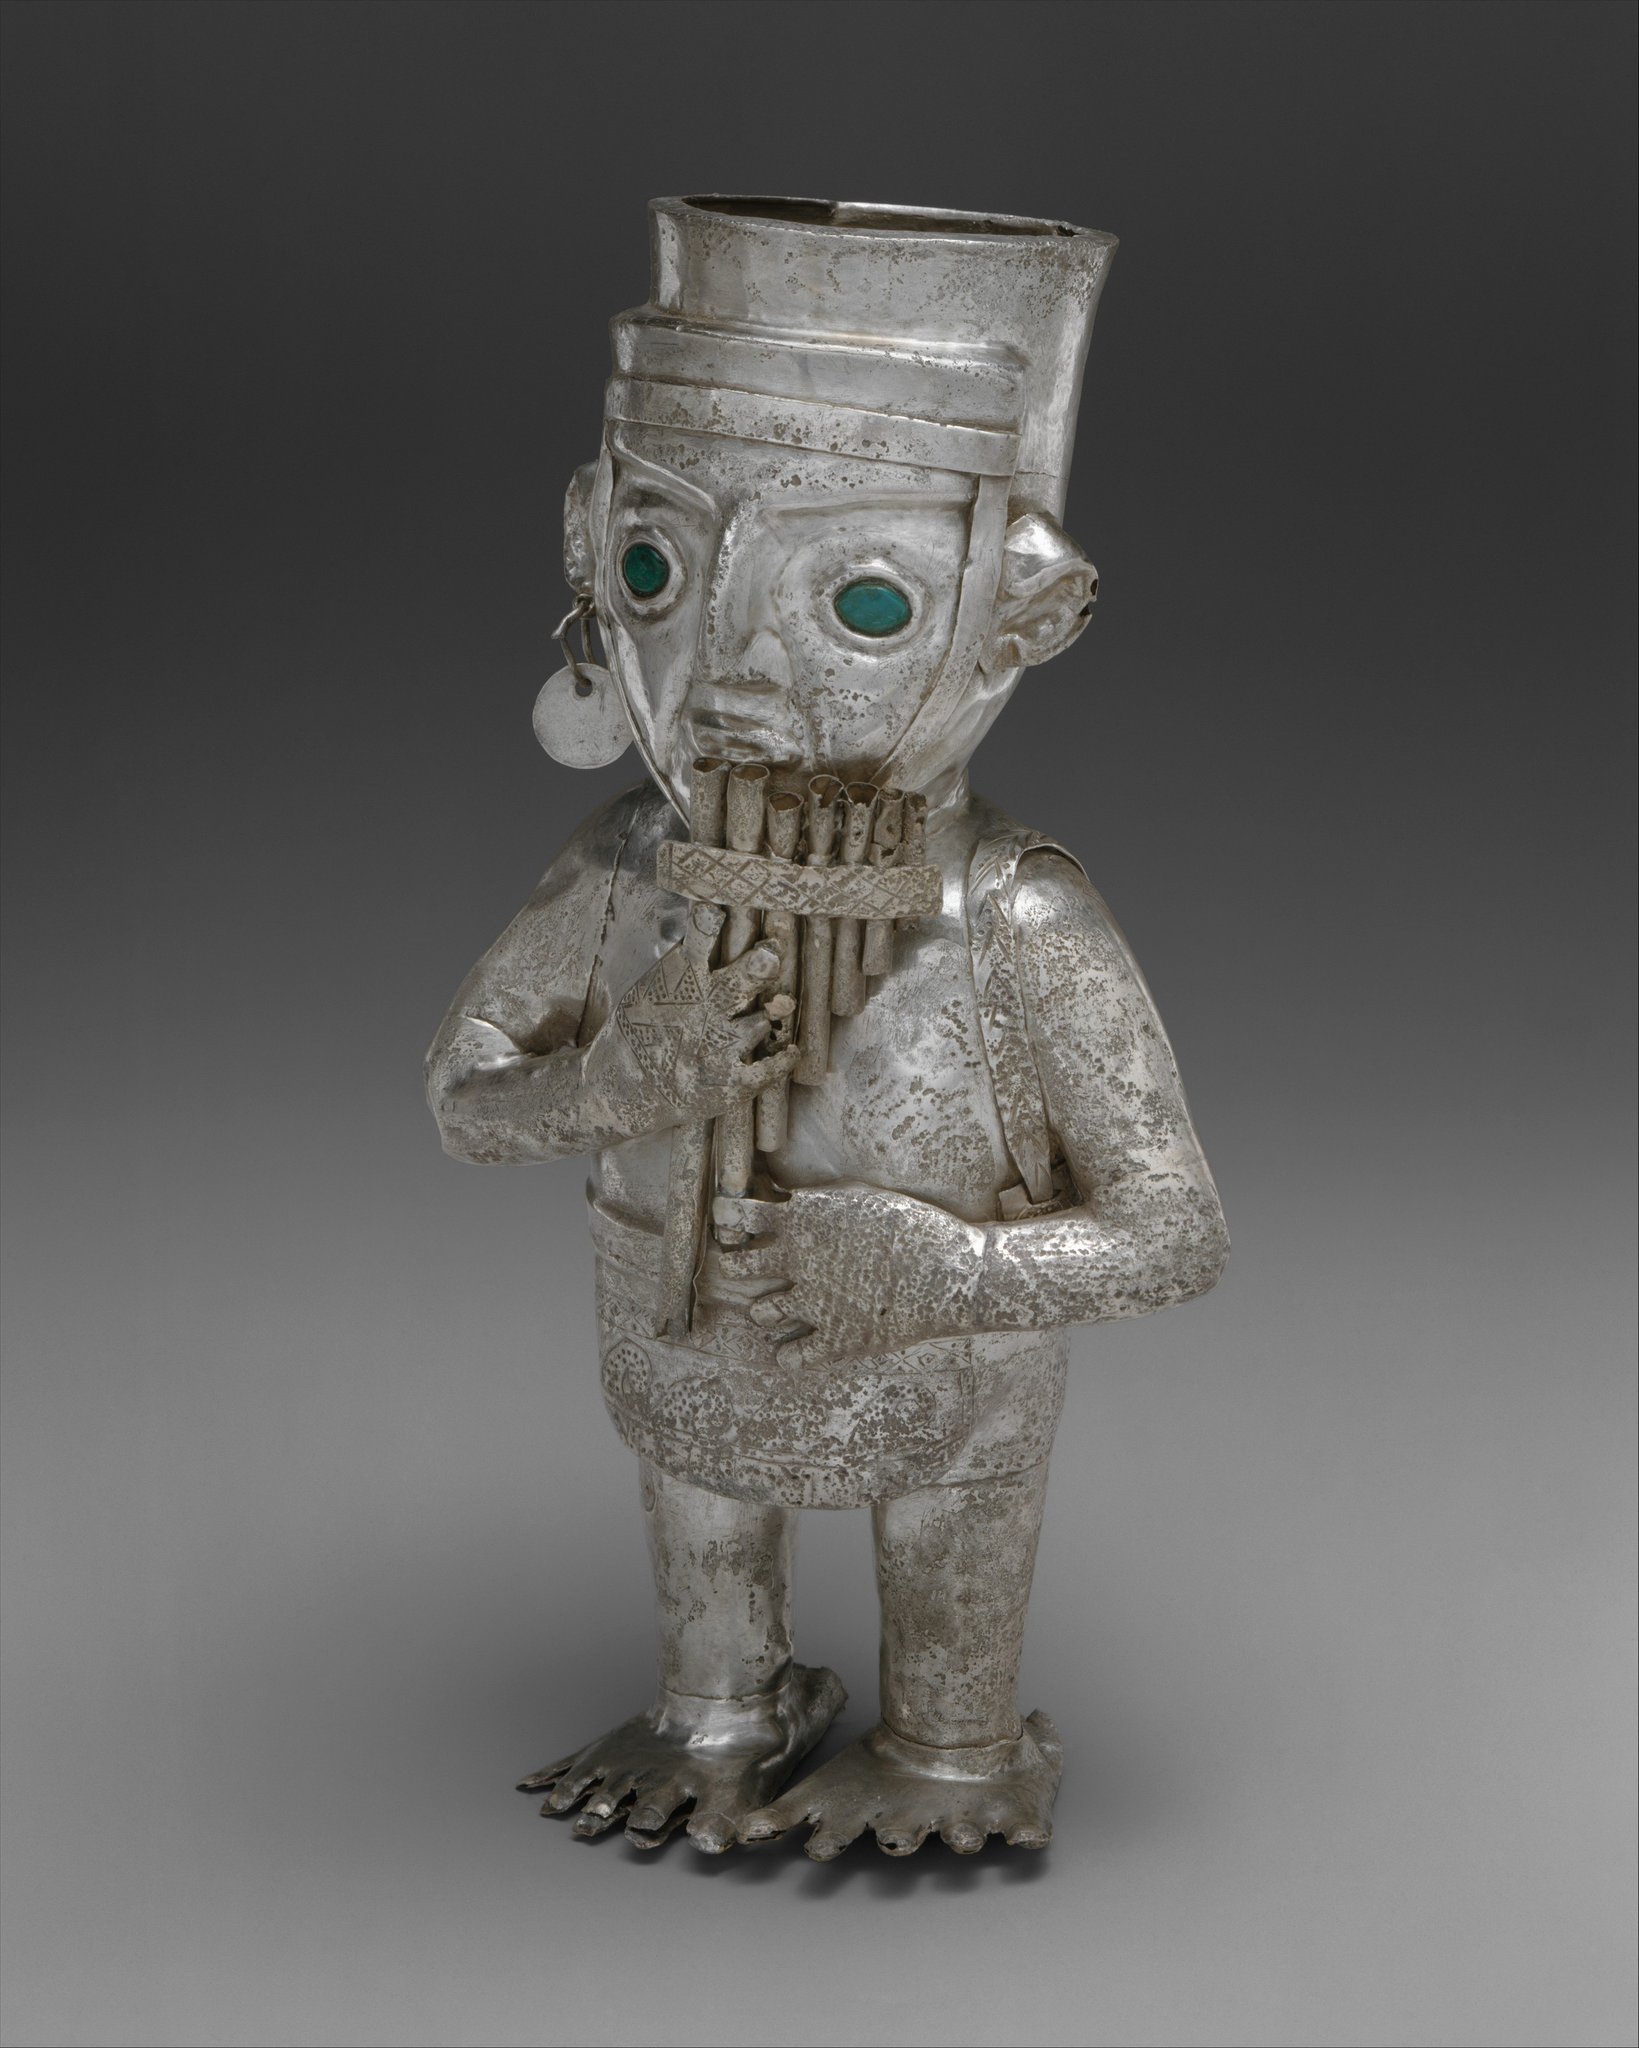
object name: vessel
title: Panpiper-shaped vessel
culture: chimú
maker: chimú artist(s)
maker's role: artist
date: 1350-1470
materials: silver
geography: peru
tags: musical instruments,men,musicians